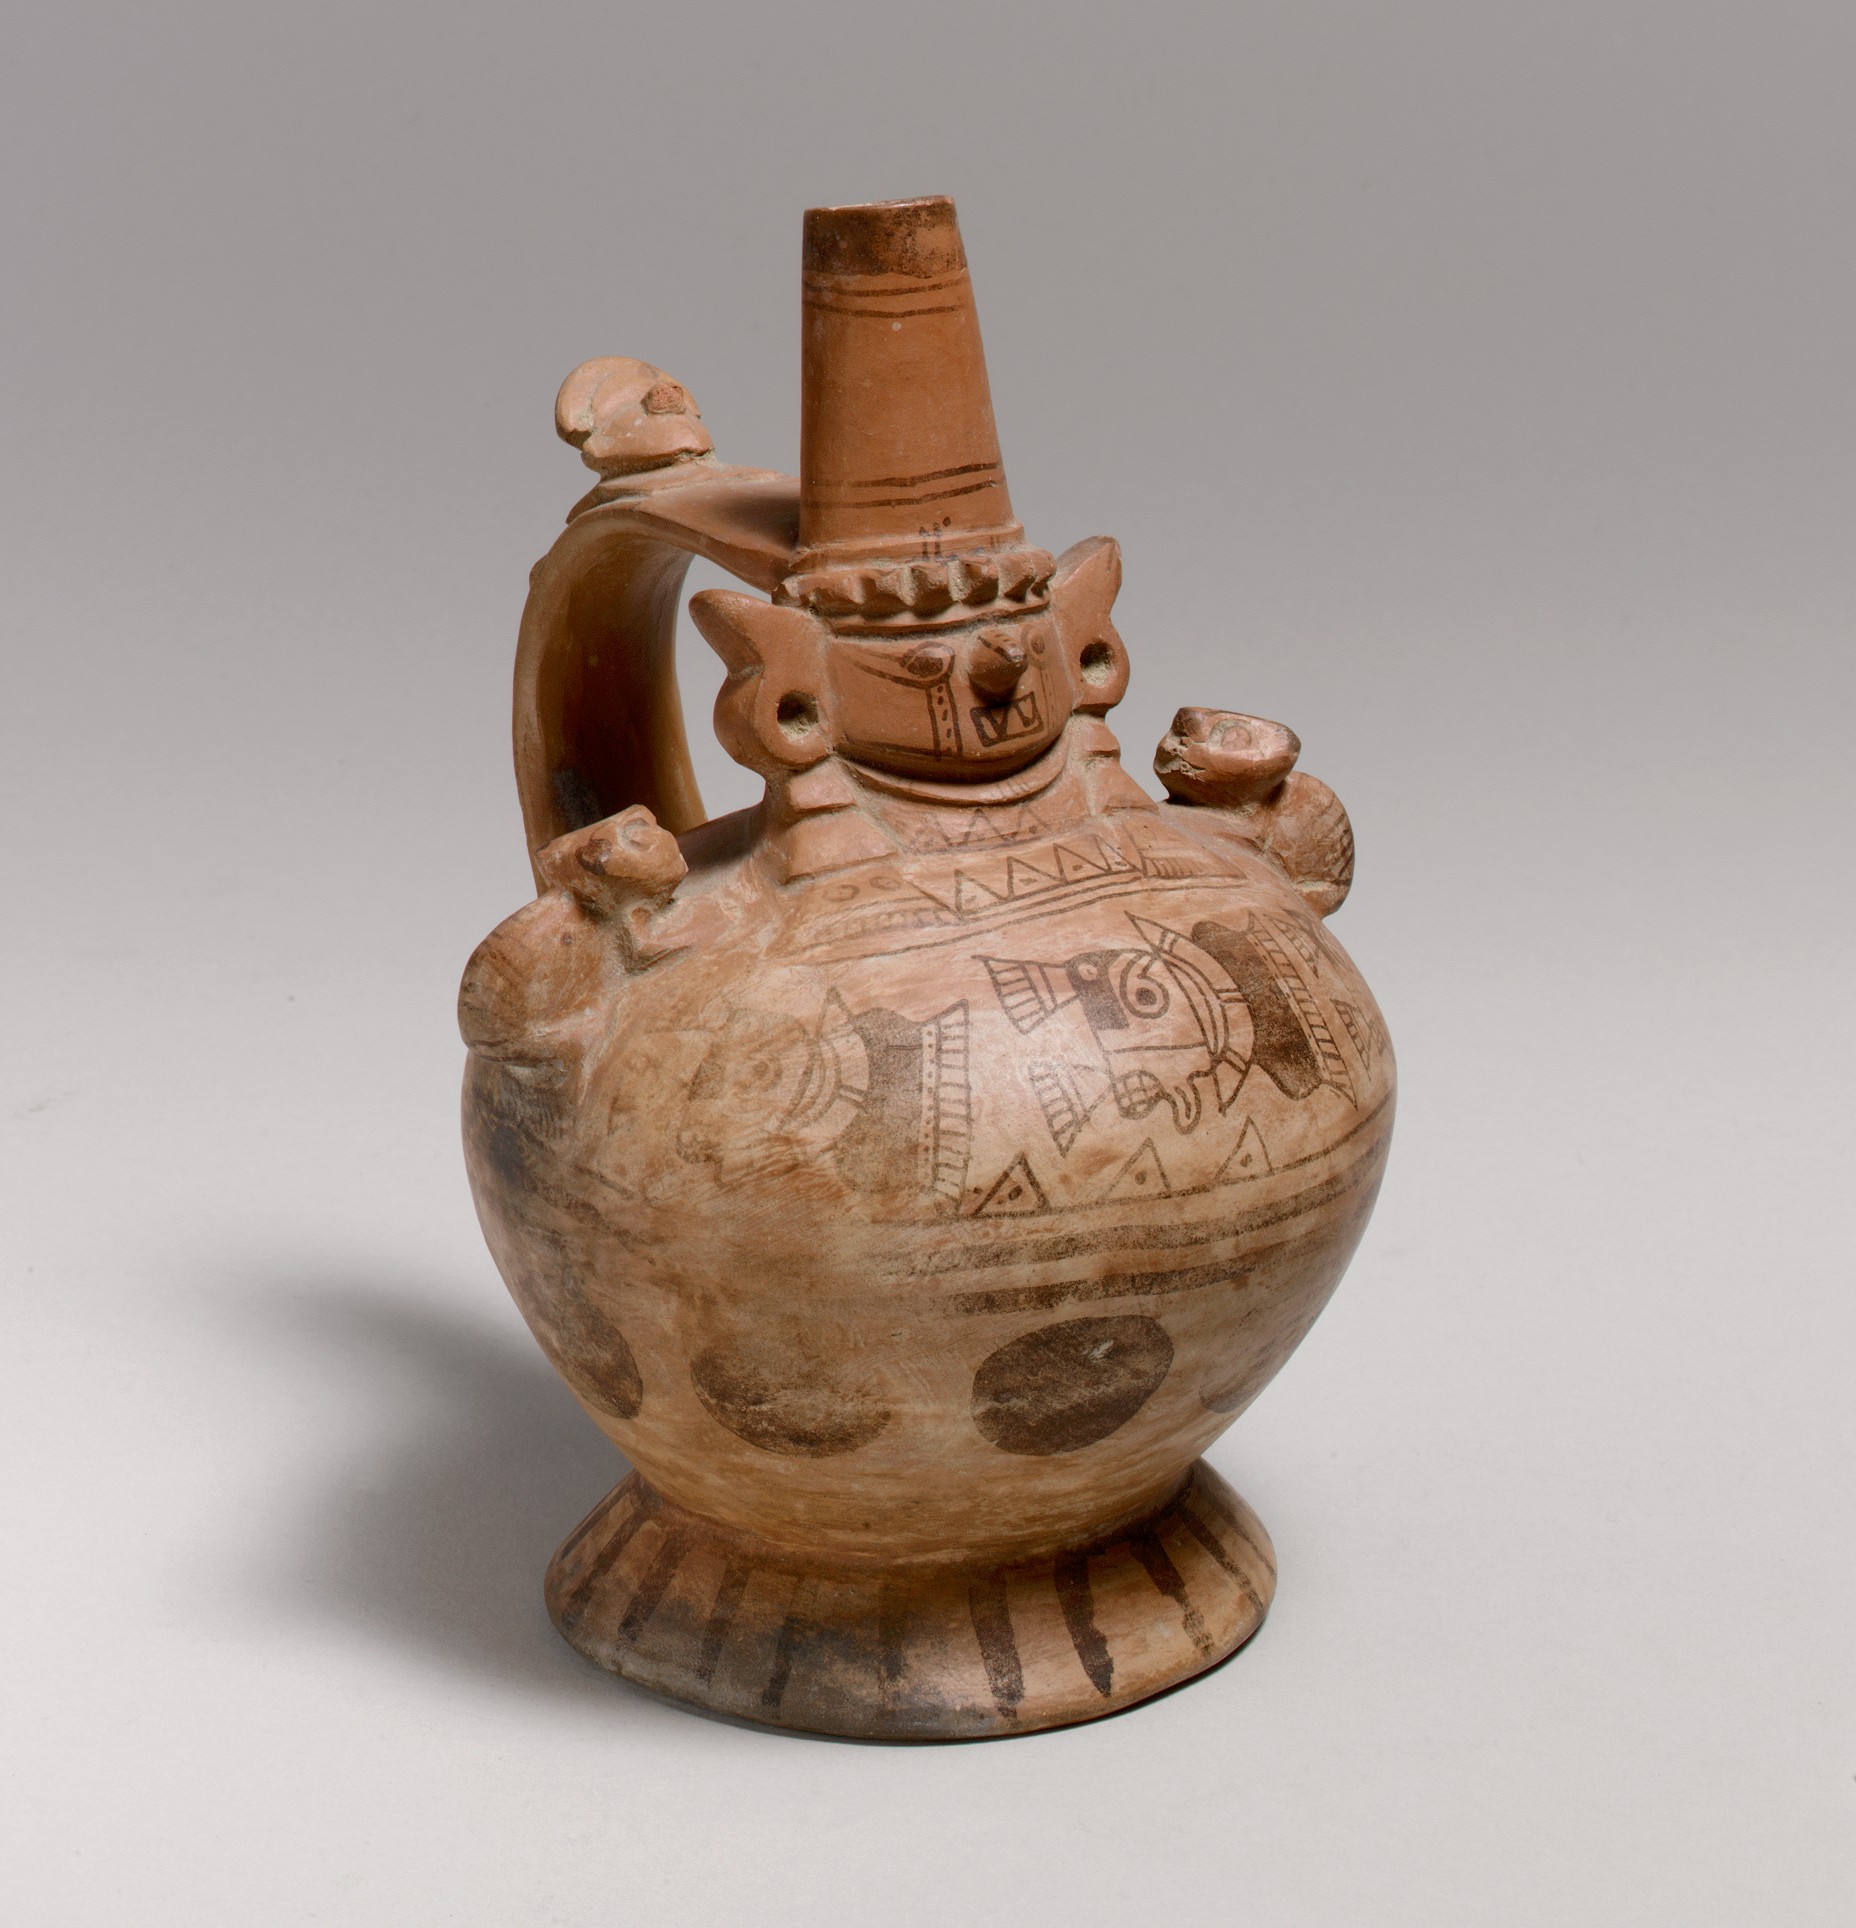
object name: bottle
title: Bottle with mythic figure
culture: lambayeque, sicán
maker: lambayeque (sicán) artist(s)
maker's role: artist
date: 900-1100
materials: ceramic, pigment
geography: peru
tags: cats